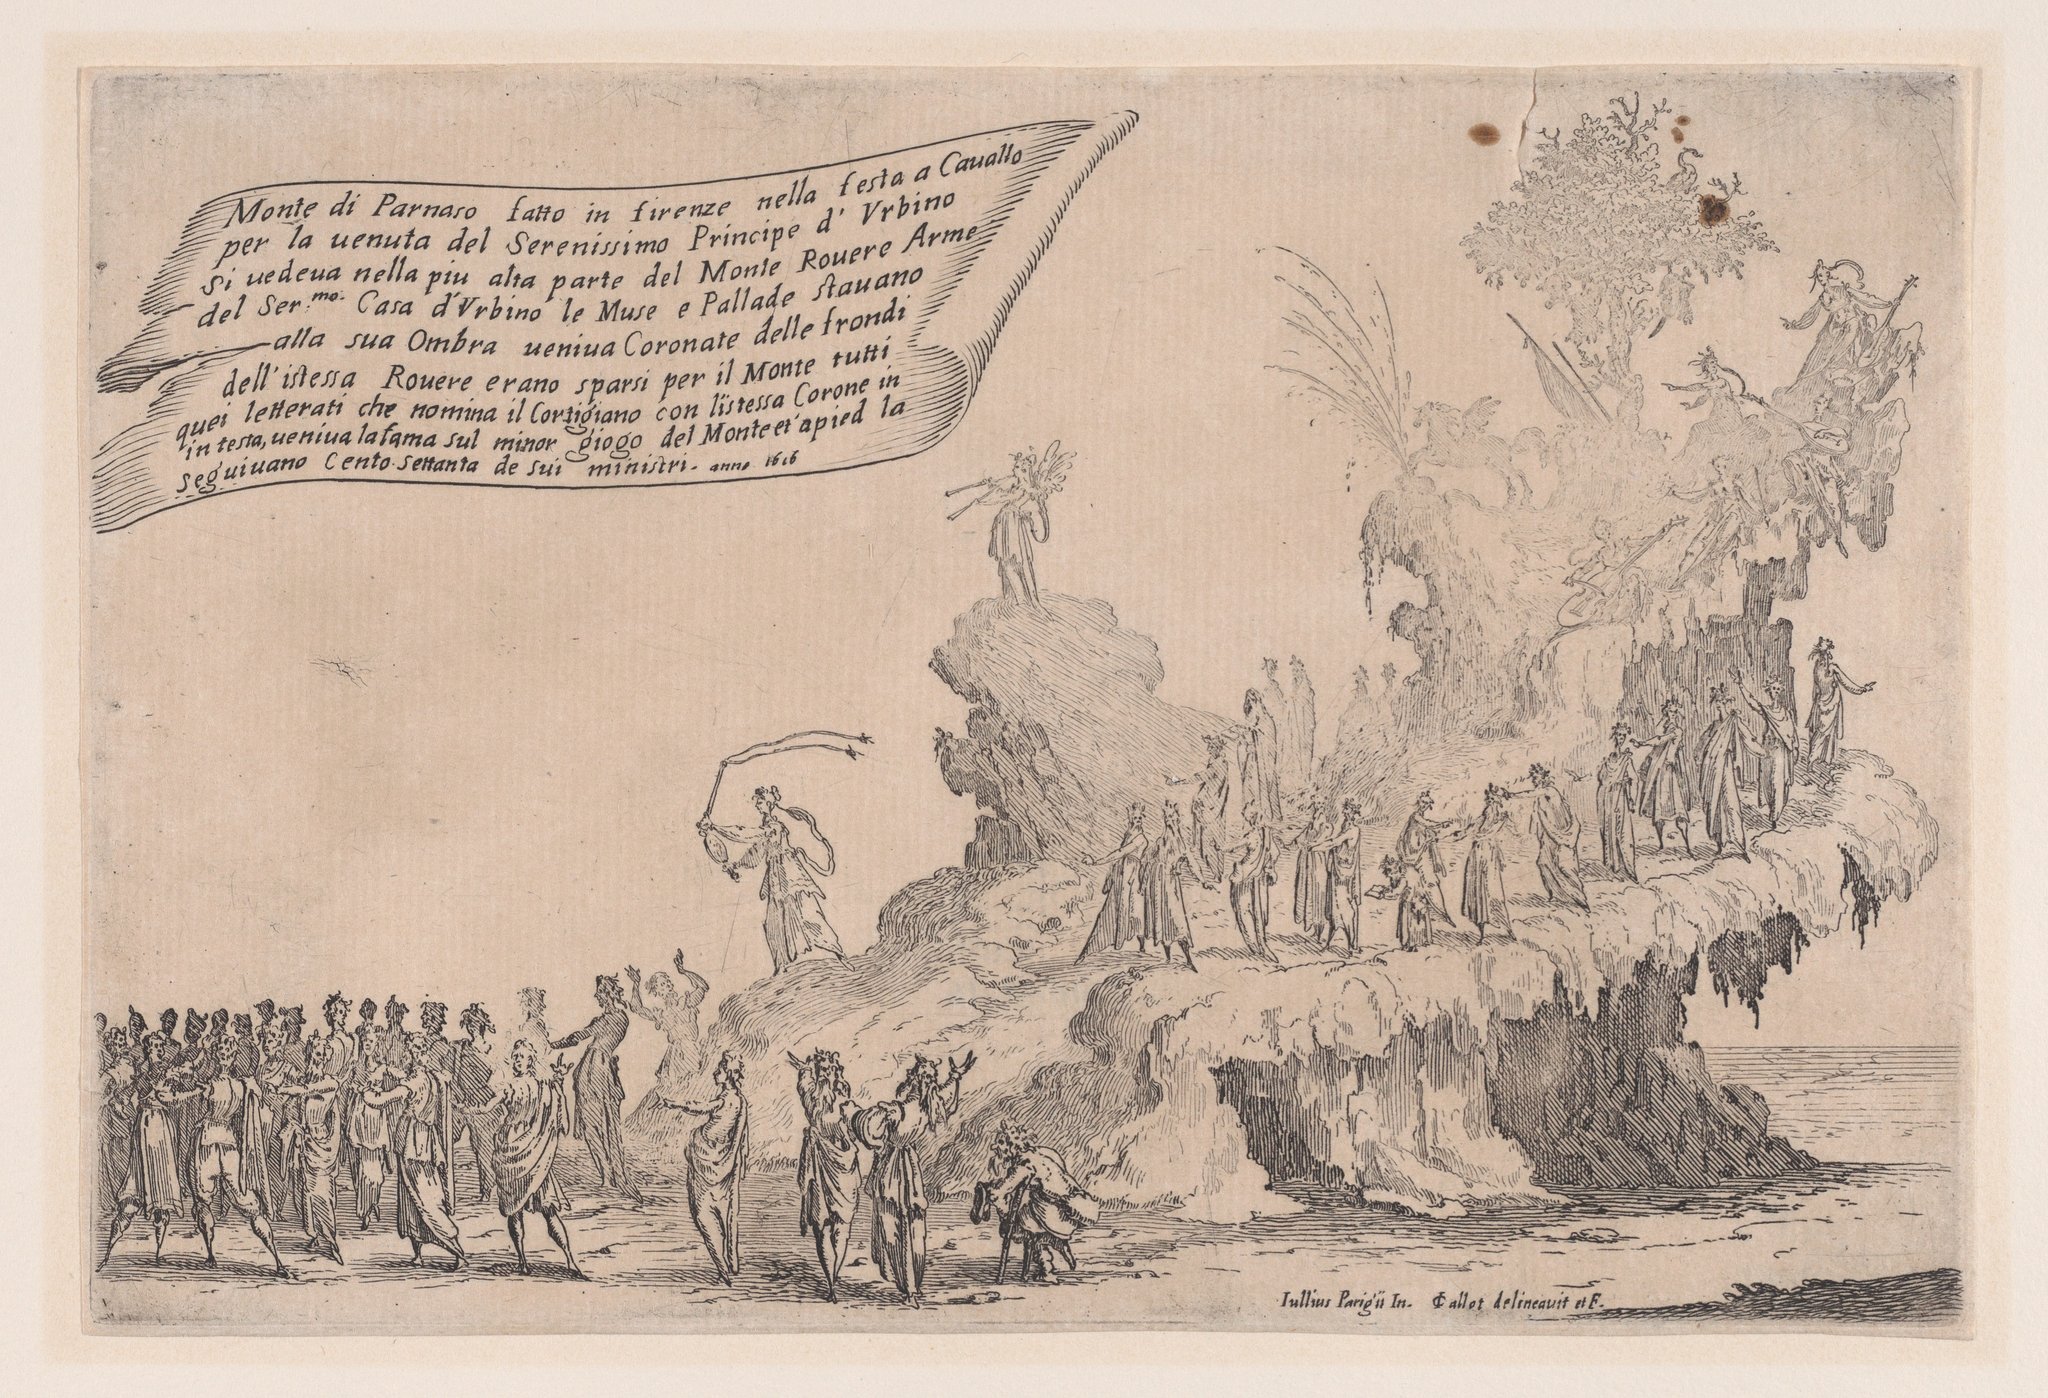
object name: print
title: Le Char du Mont Parnasse (The Chariot of Mount Parnassus), from "Guerre de Beauté" (Guerra di Bellezza) (War of Beauty)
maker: jacques callot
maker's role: artist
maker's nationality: french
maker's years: 1592-1635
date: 1616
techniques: etching